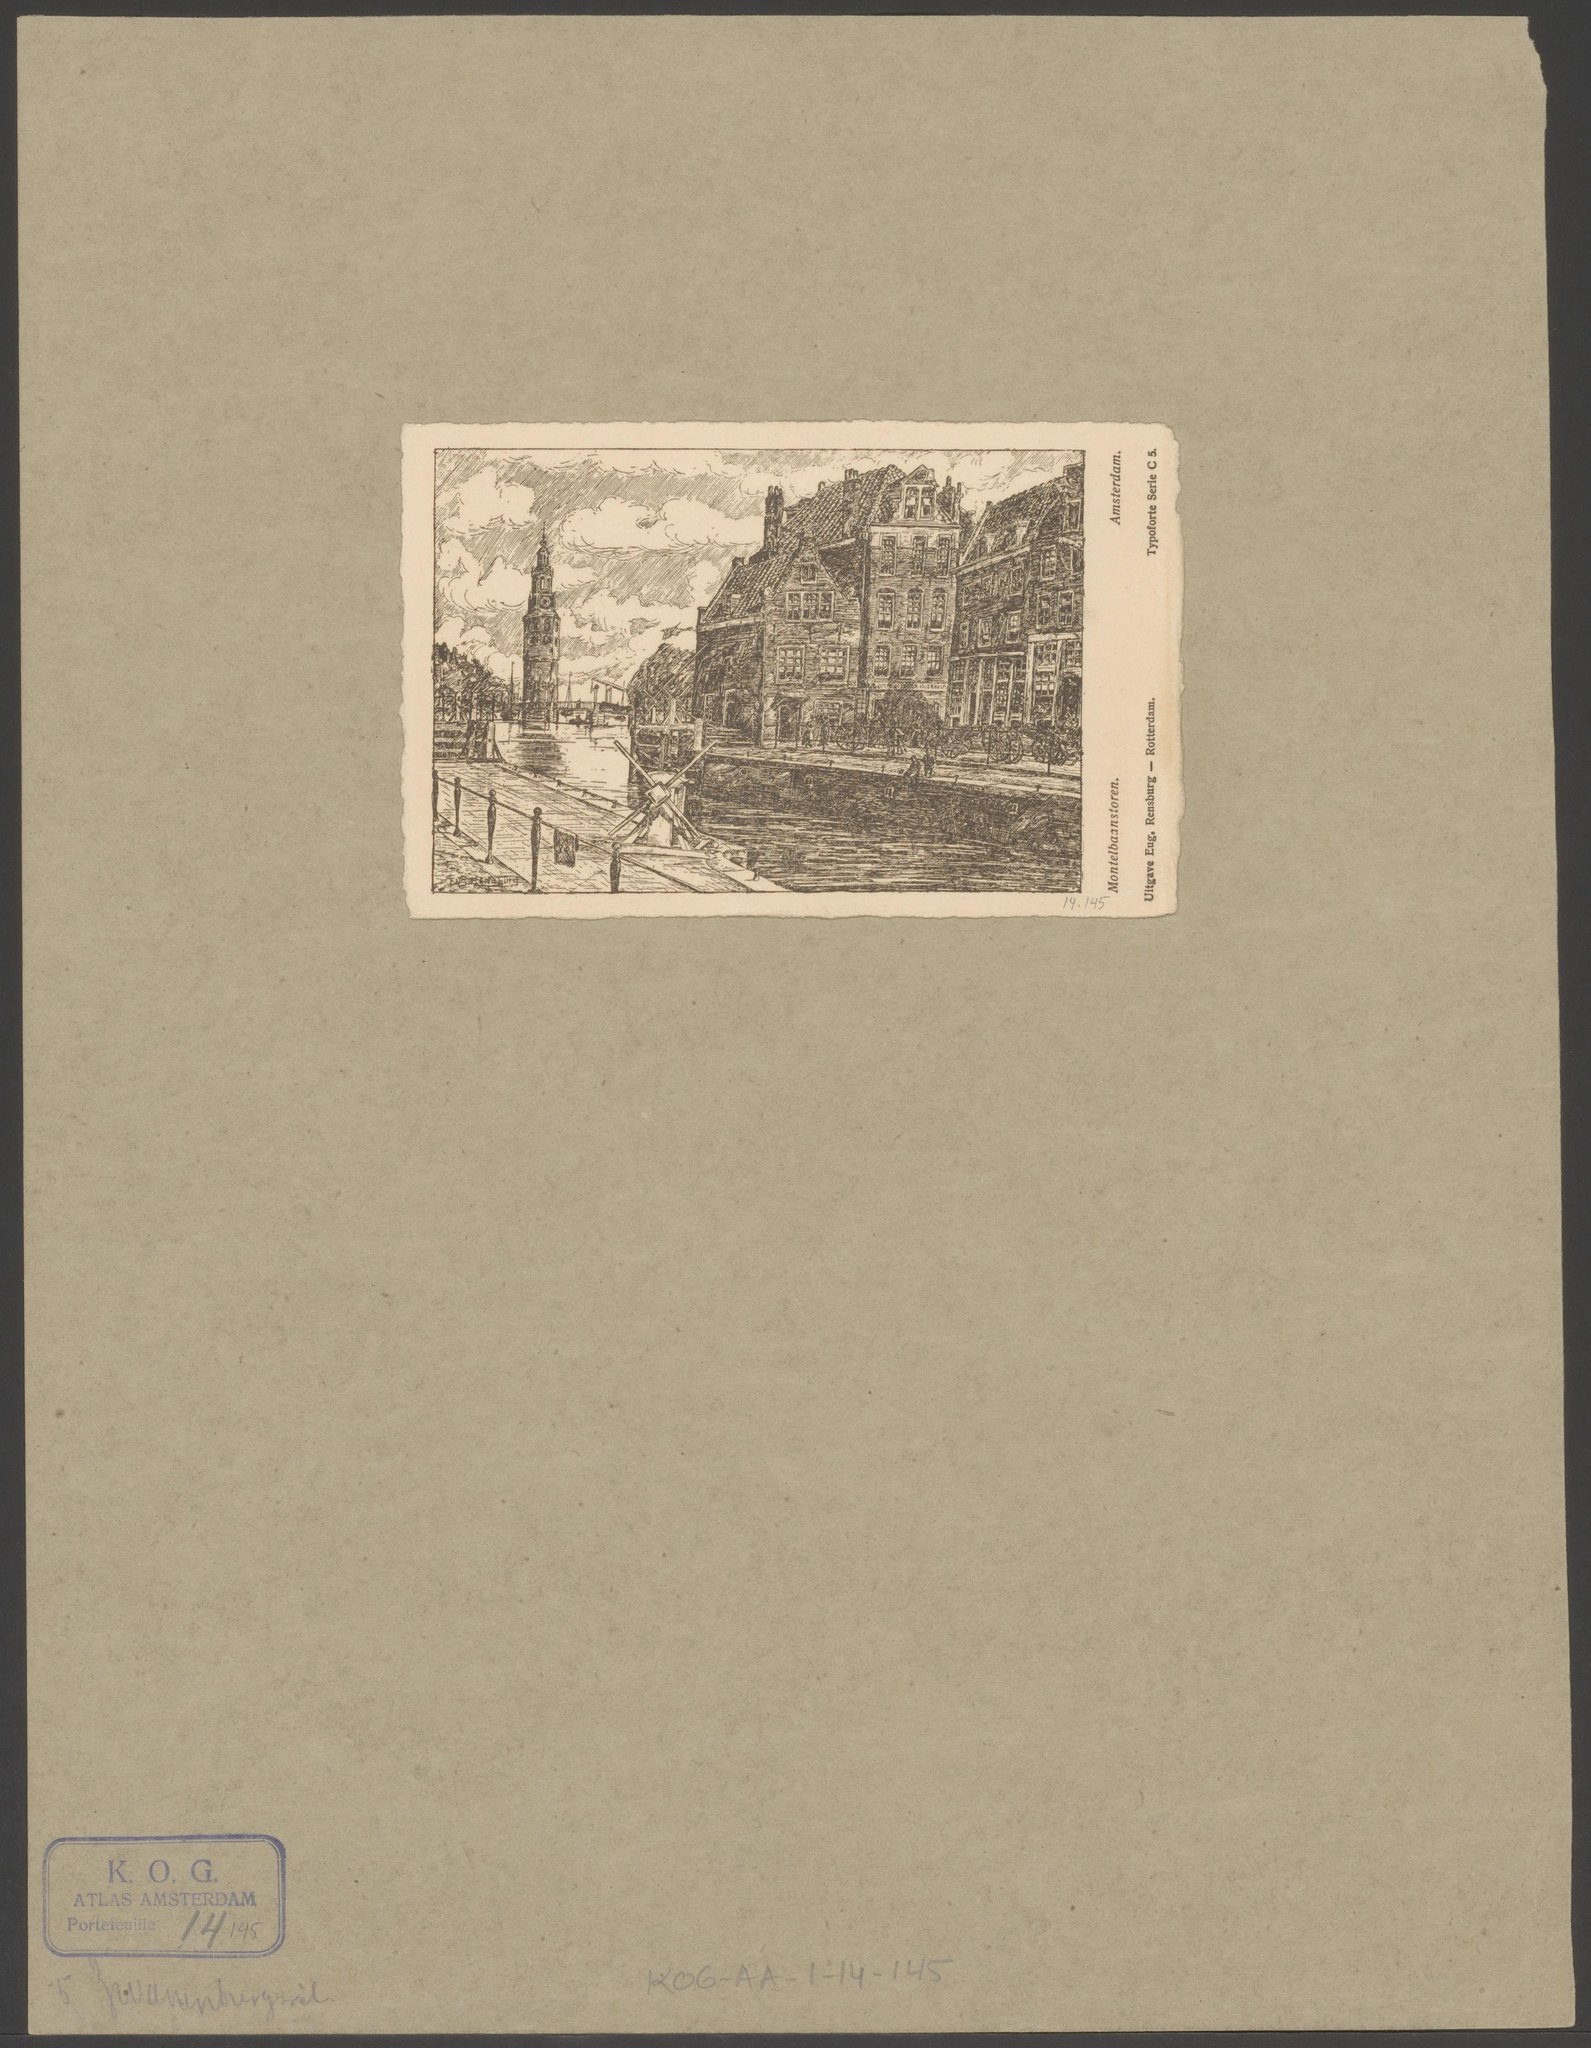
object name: ansichtkaart, prentbriefkaart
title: Gezicht op de Zwanenburgwal met de Montelbaanstoren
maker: eugène rensburg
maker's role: draughtsman, print maker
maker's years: 1872-1956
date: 1905-1956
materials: paper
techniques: letterpress printing, line block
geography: rotterdam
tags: tower, clock tower ~ monumental adornment, city-view in general; 'veduta', canal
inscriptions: inscription: ‘5 Zwanenburgwal’, collector's mark: ‘14 145’ Lugt 1641b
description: Onderwerpsrubriek binnen de Atlas Amsterdam: Zaagmolensloot, Zandpad, Zeeburg, Zeeburgerdijk, Zeeburgerpad, Zeeburgerstraat, Zwanenburgwal, Zwartebijlsteeg.